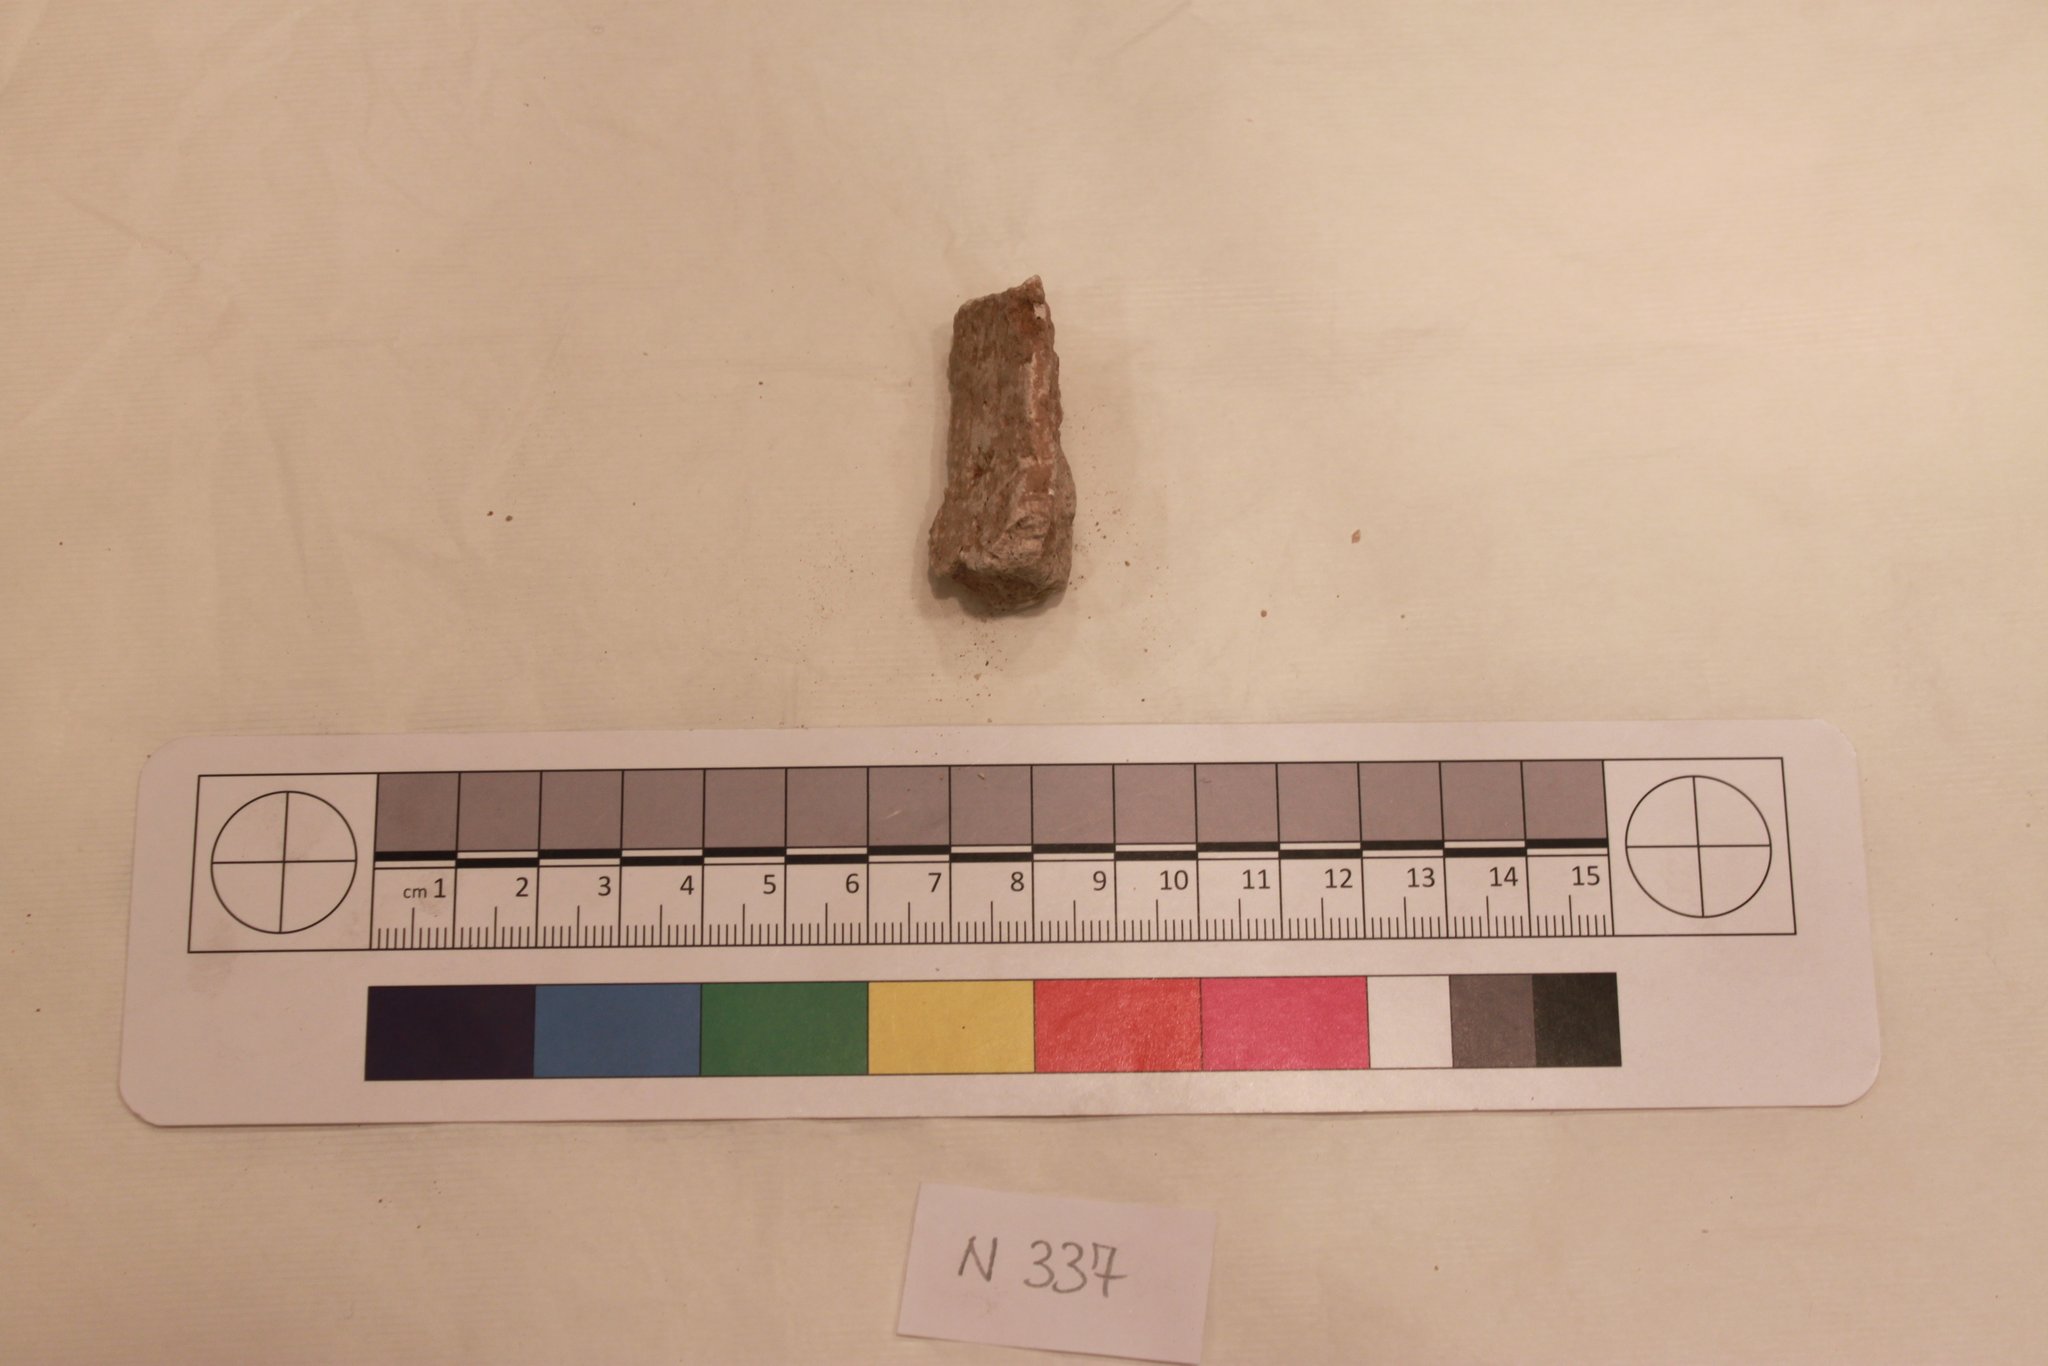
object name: fragment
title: Stucco Fragment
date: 701-1200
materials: plaster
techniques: carving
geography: iran